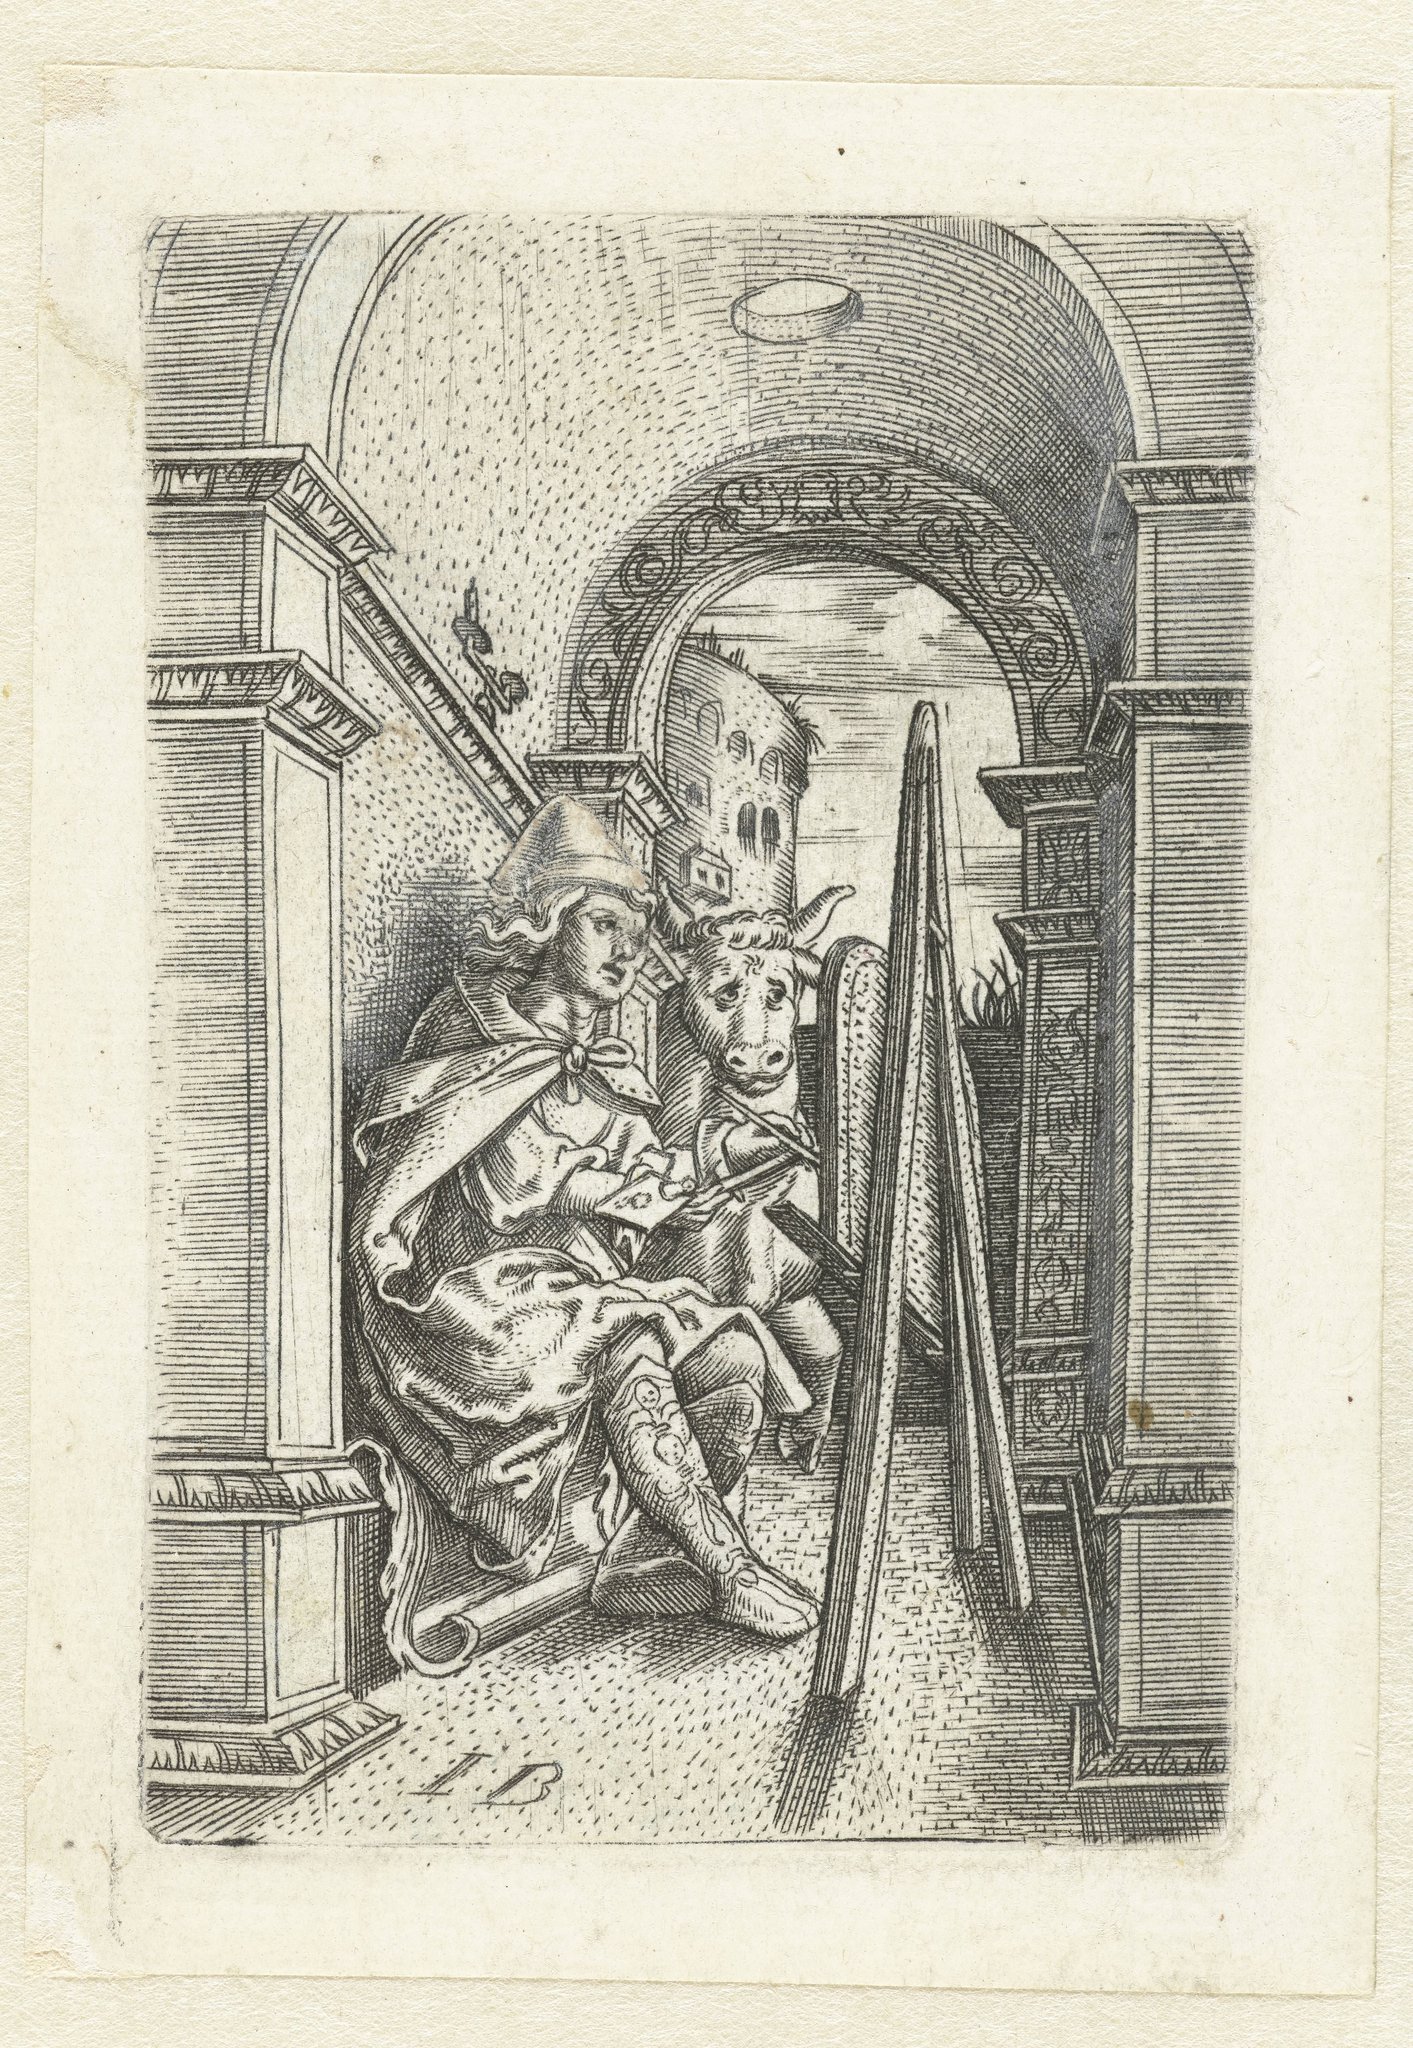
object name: print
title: Heilige Lucas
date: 1525-1530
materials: paper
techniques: engraving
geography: germany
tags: st. luke as patron of painters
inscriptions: collector's mark: Lugt 2233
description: De heilige Lucas aan het schilderen, zittend achter zijn ezel in een gallerij. Naast hem de os.